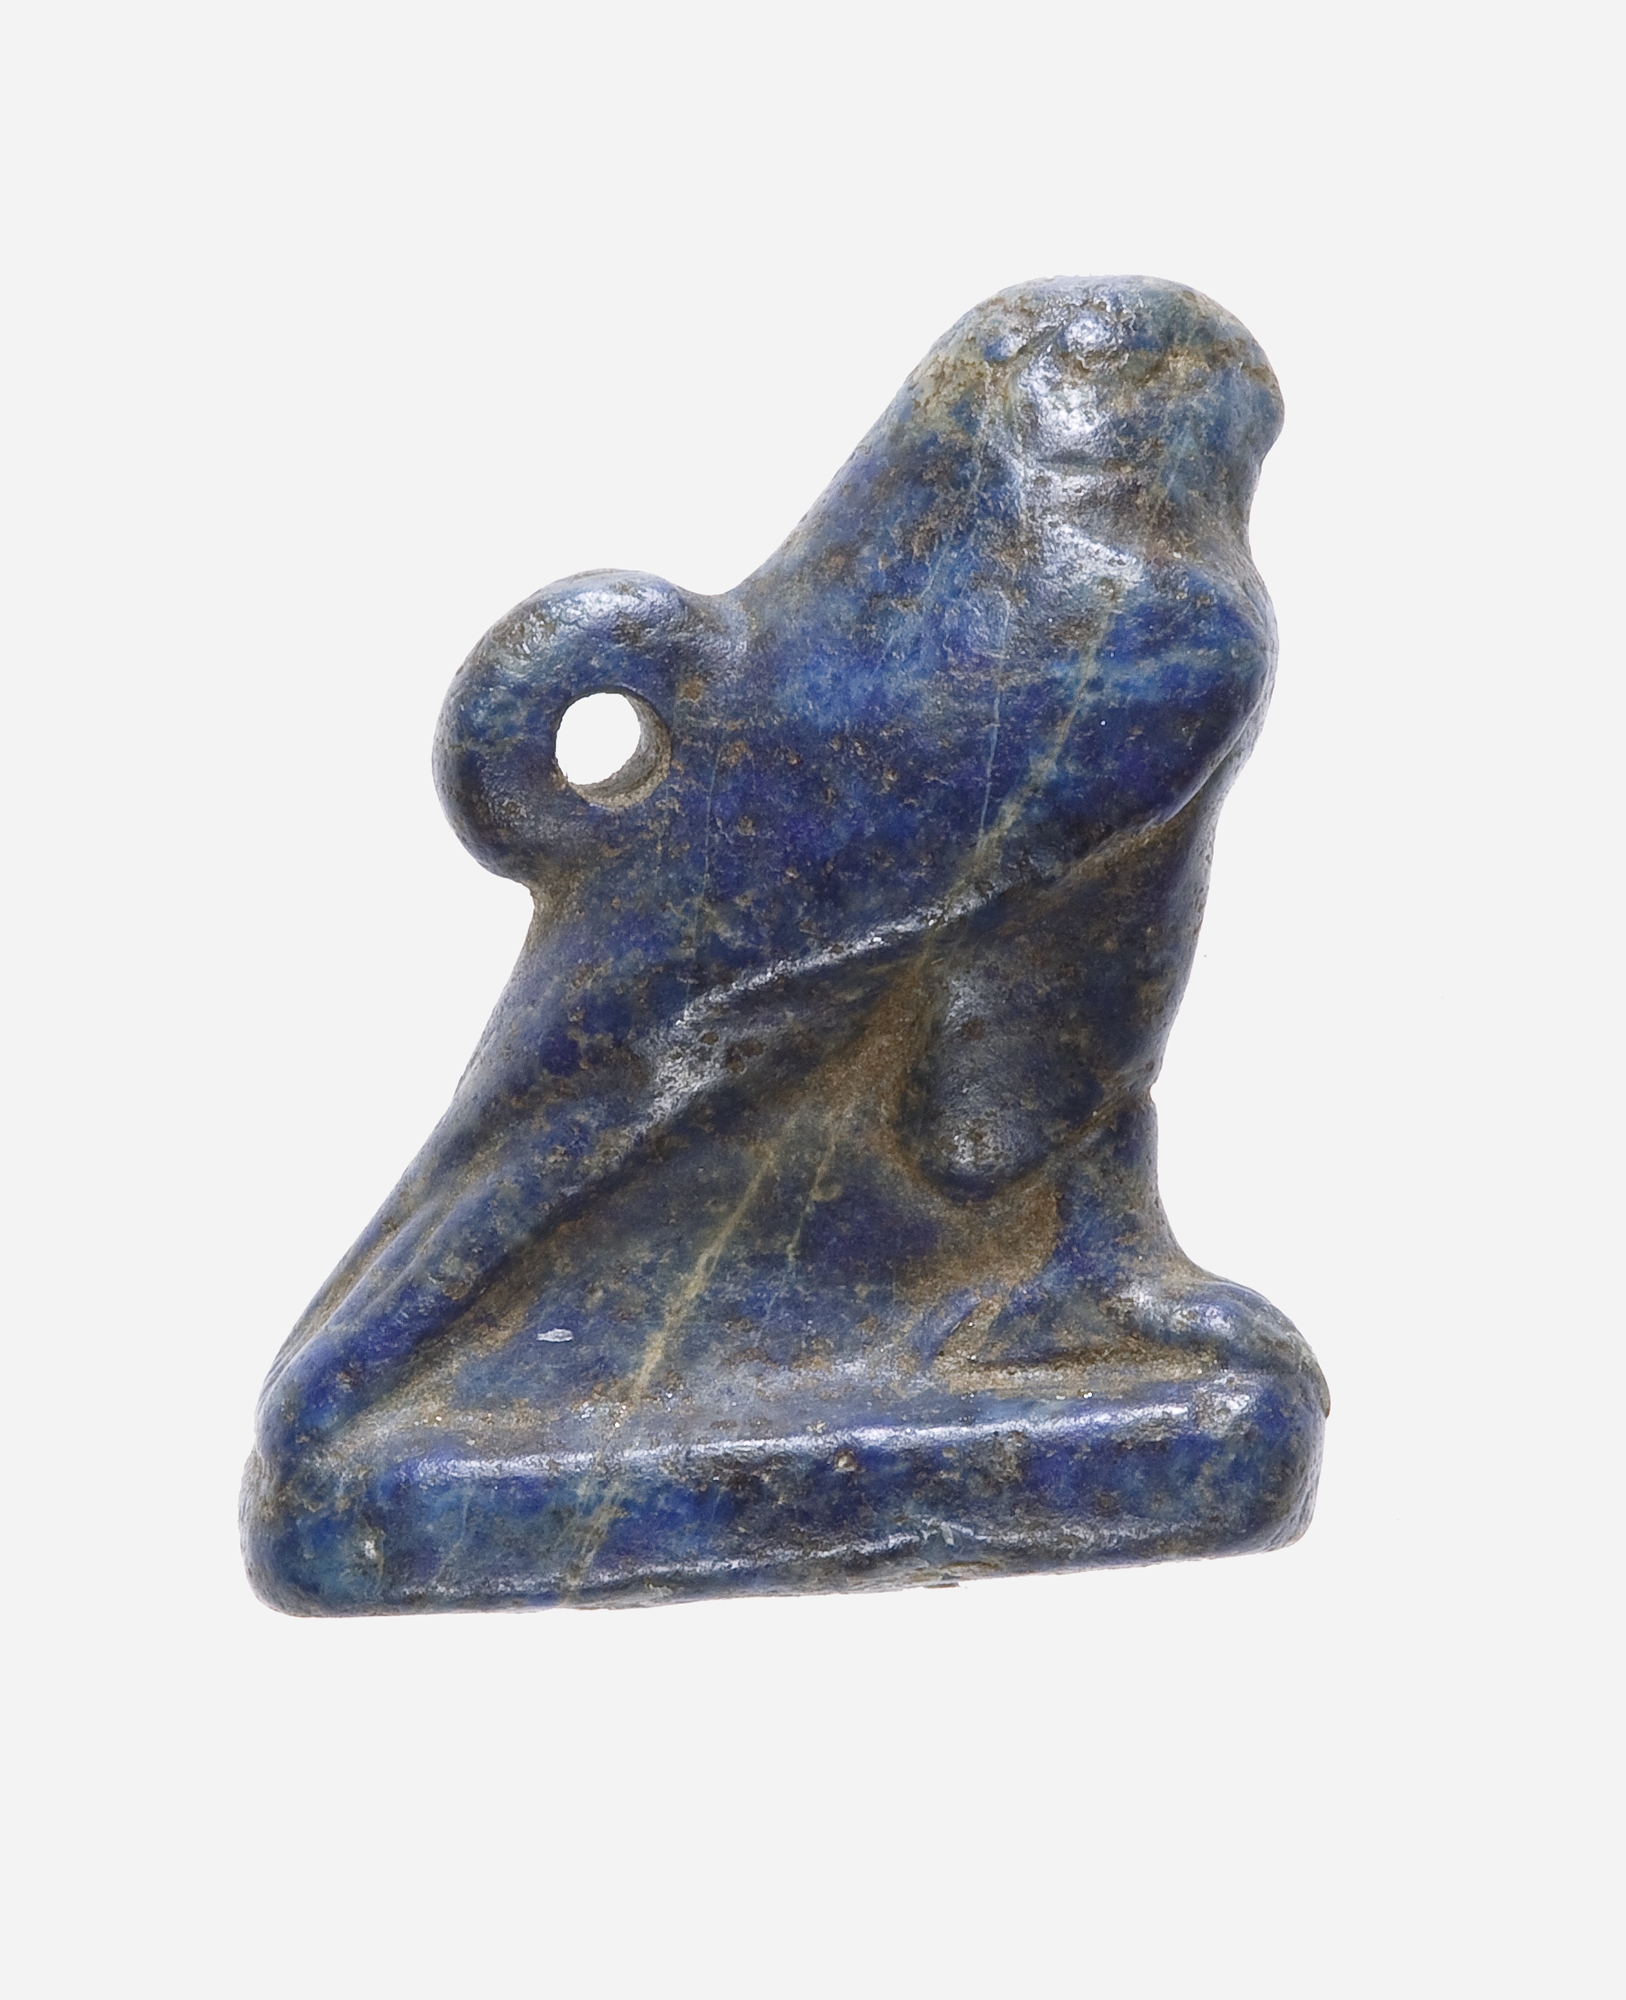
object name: amulet, falcon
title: Falcon amulet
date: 664-332 BCE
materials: lapis lazuli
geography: egypt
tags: falcons